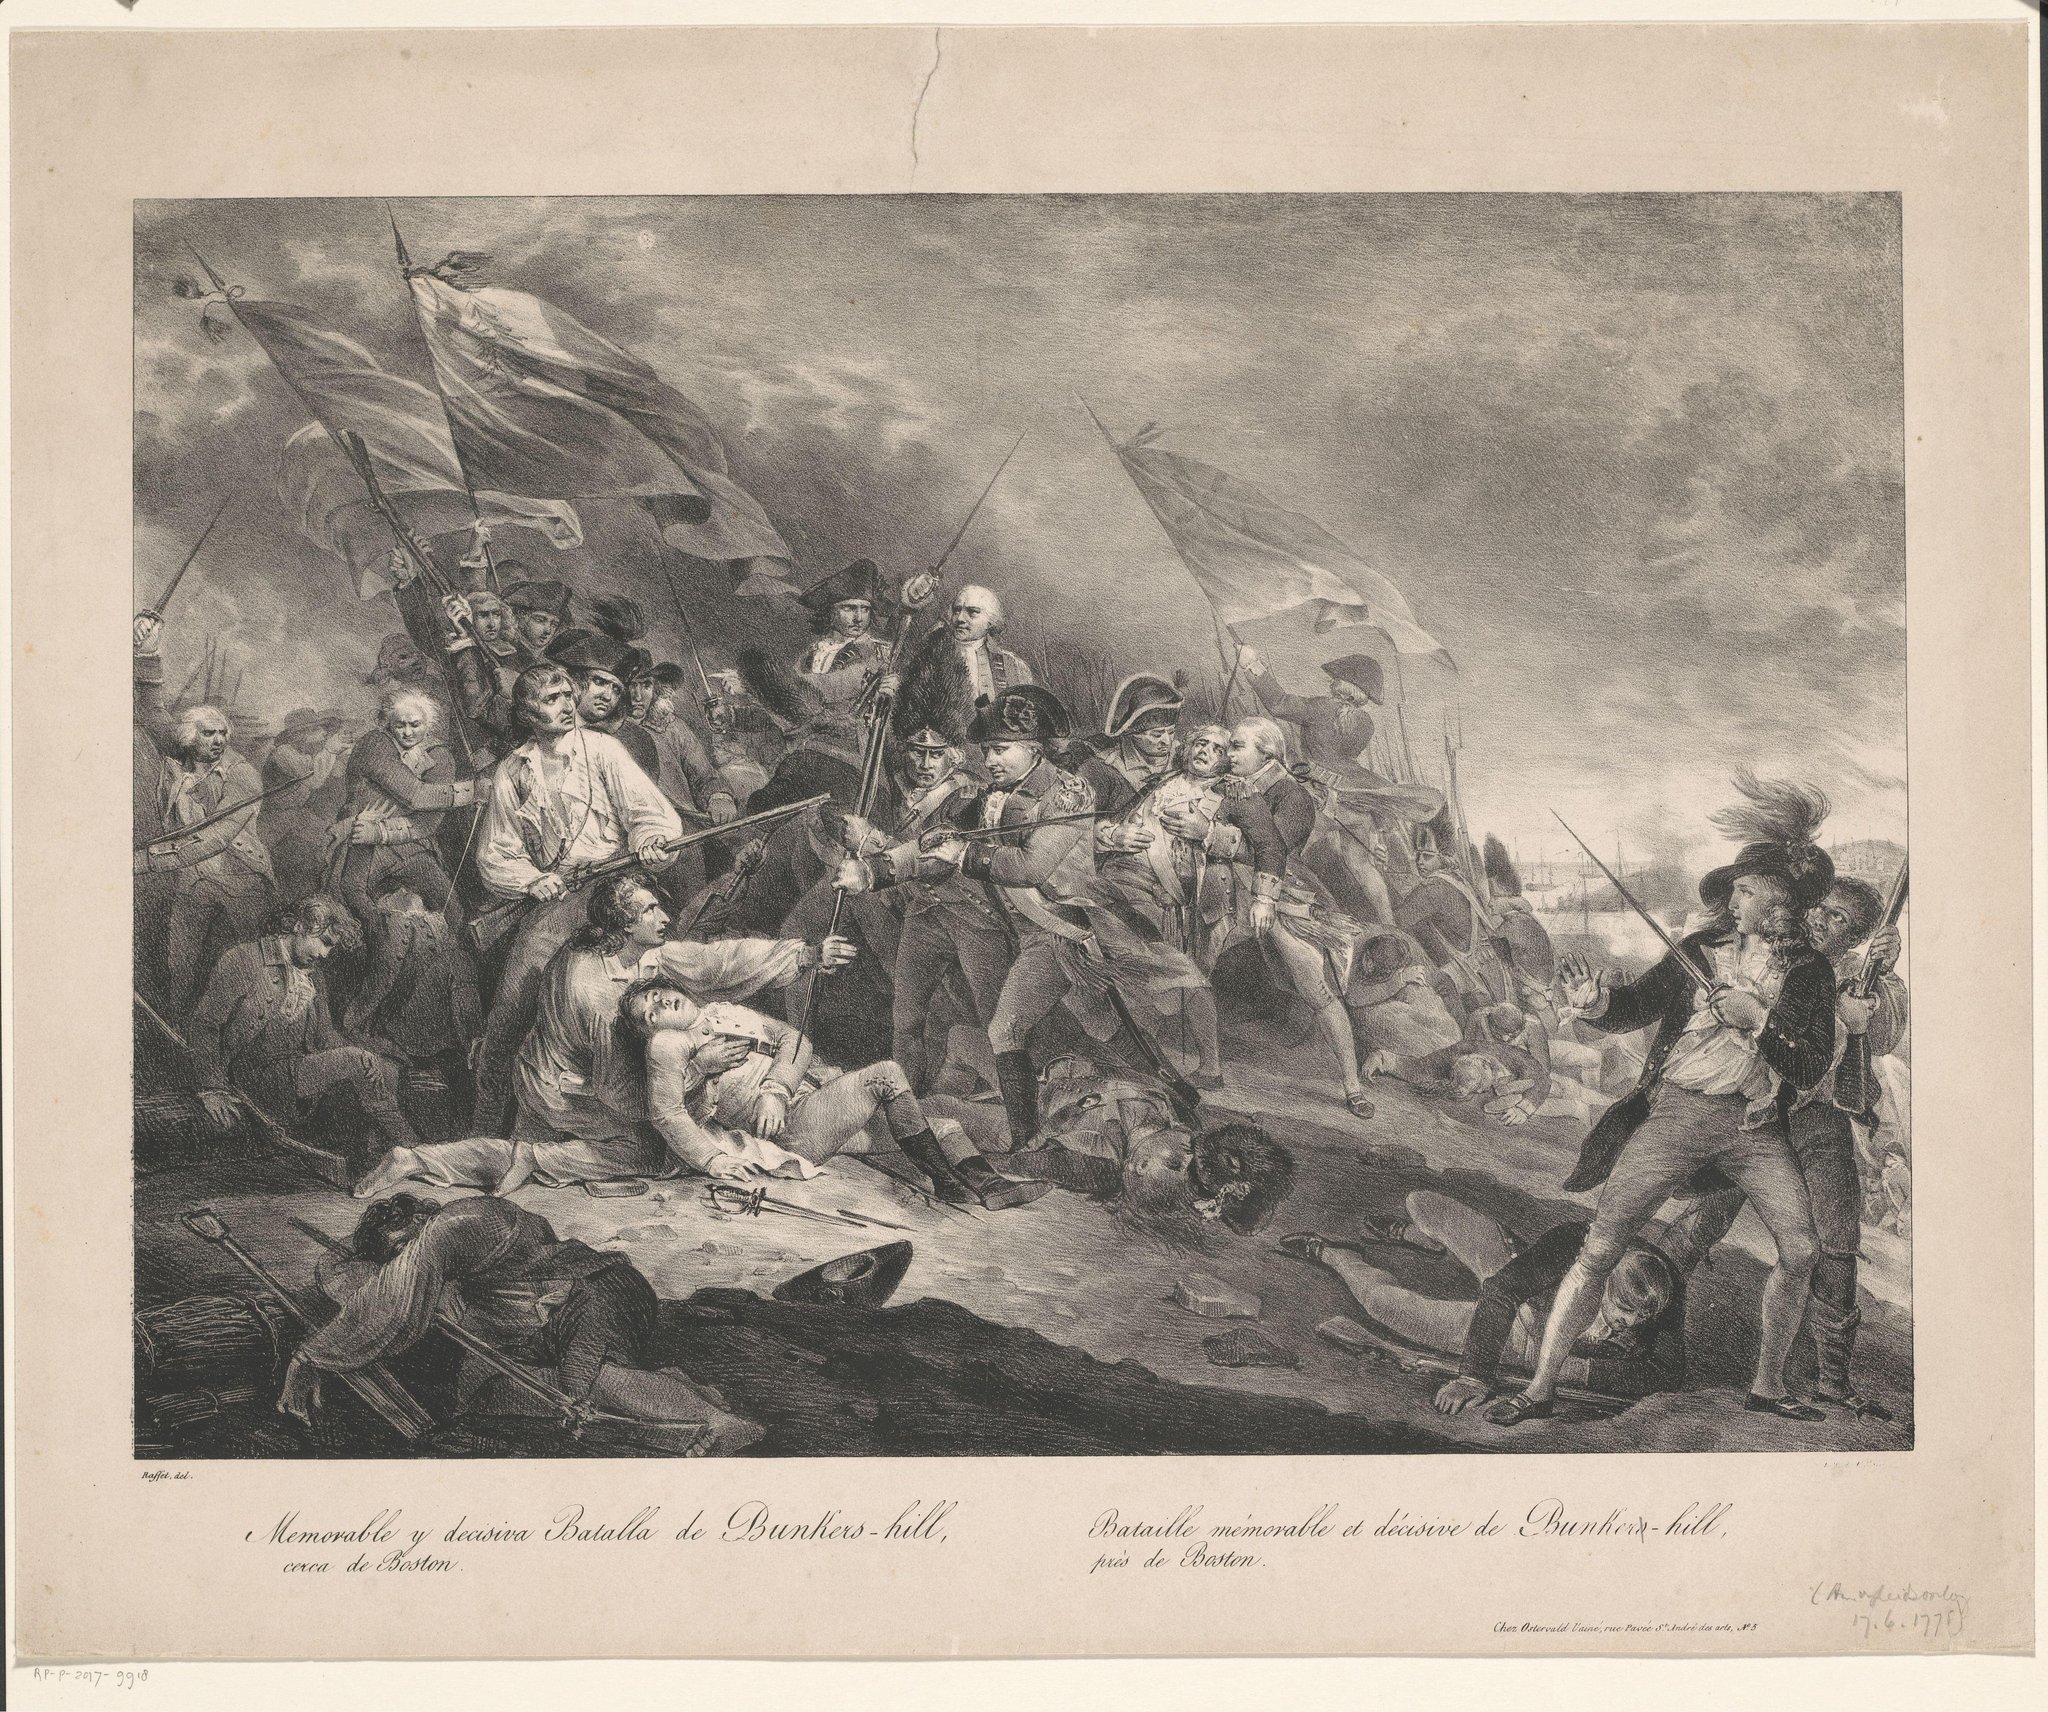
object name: print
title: Slag om Bunker Hill, 1775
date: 1817-1840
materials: paper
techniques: lithograph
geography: paris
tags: death of an adult person, battle (+ land forces)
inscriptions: collector's mark: Lugt 2228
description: Slag om Bunker Hill, 17 juni 1775, tussen de Amerikaanse revolutionairen en de Britse Strijdkrachten. Centraal het sterven van de Amerikaanse generaal Joseph Warren. Naar het schilderij van John Trumbull.